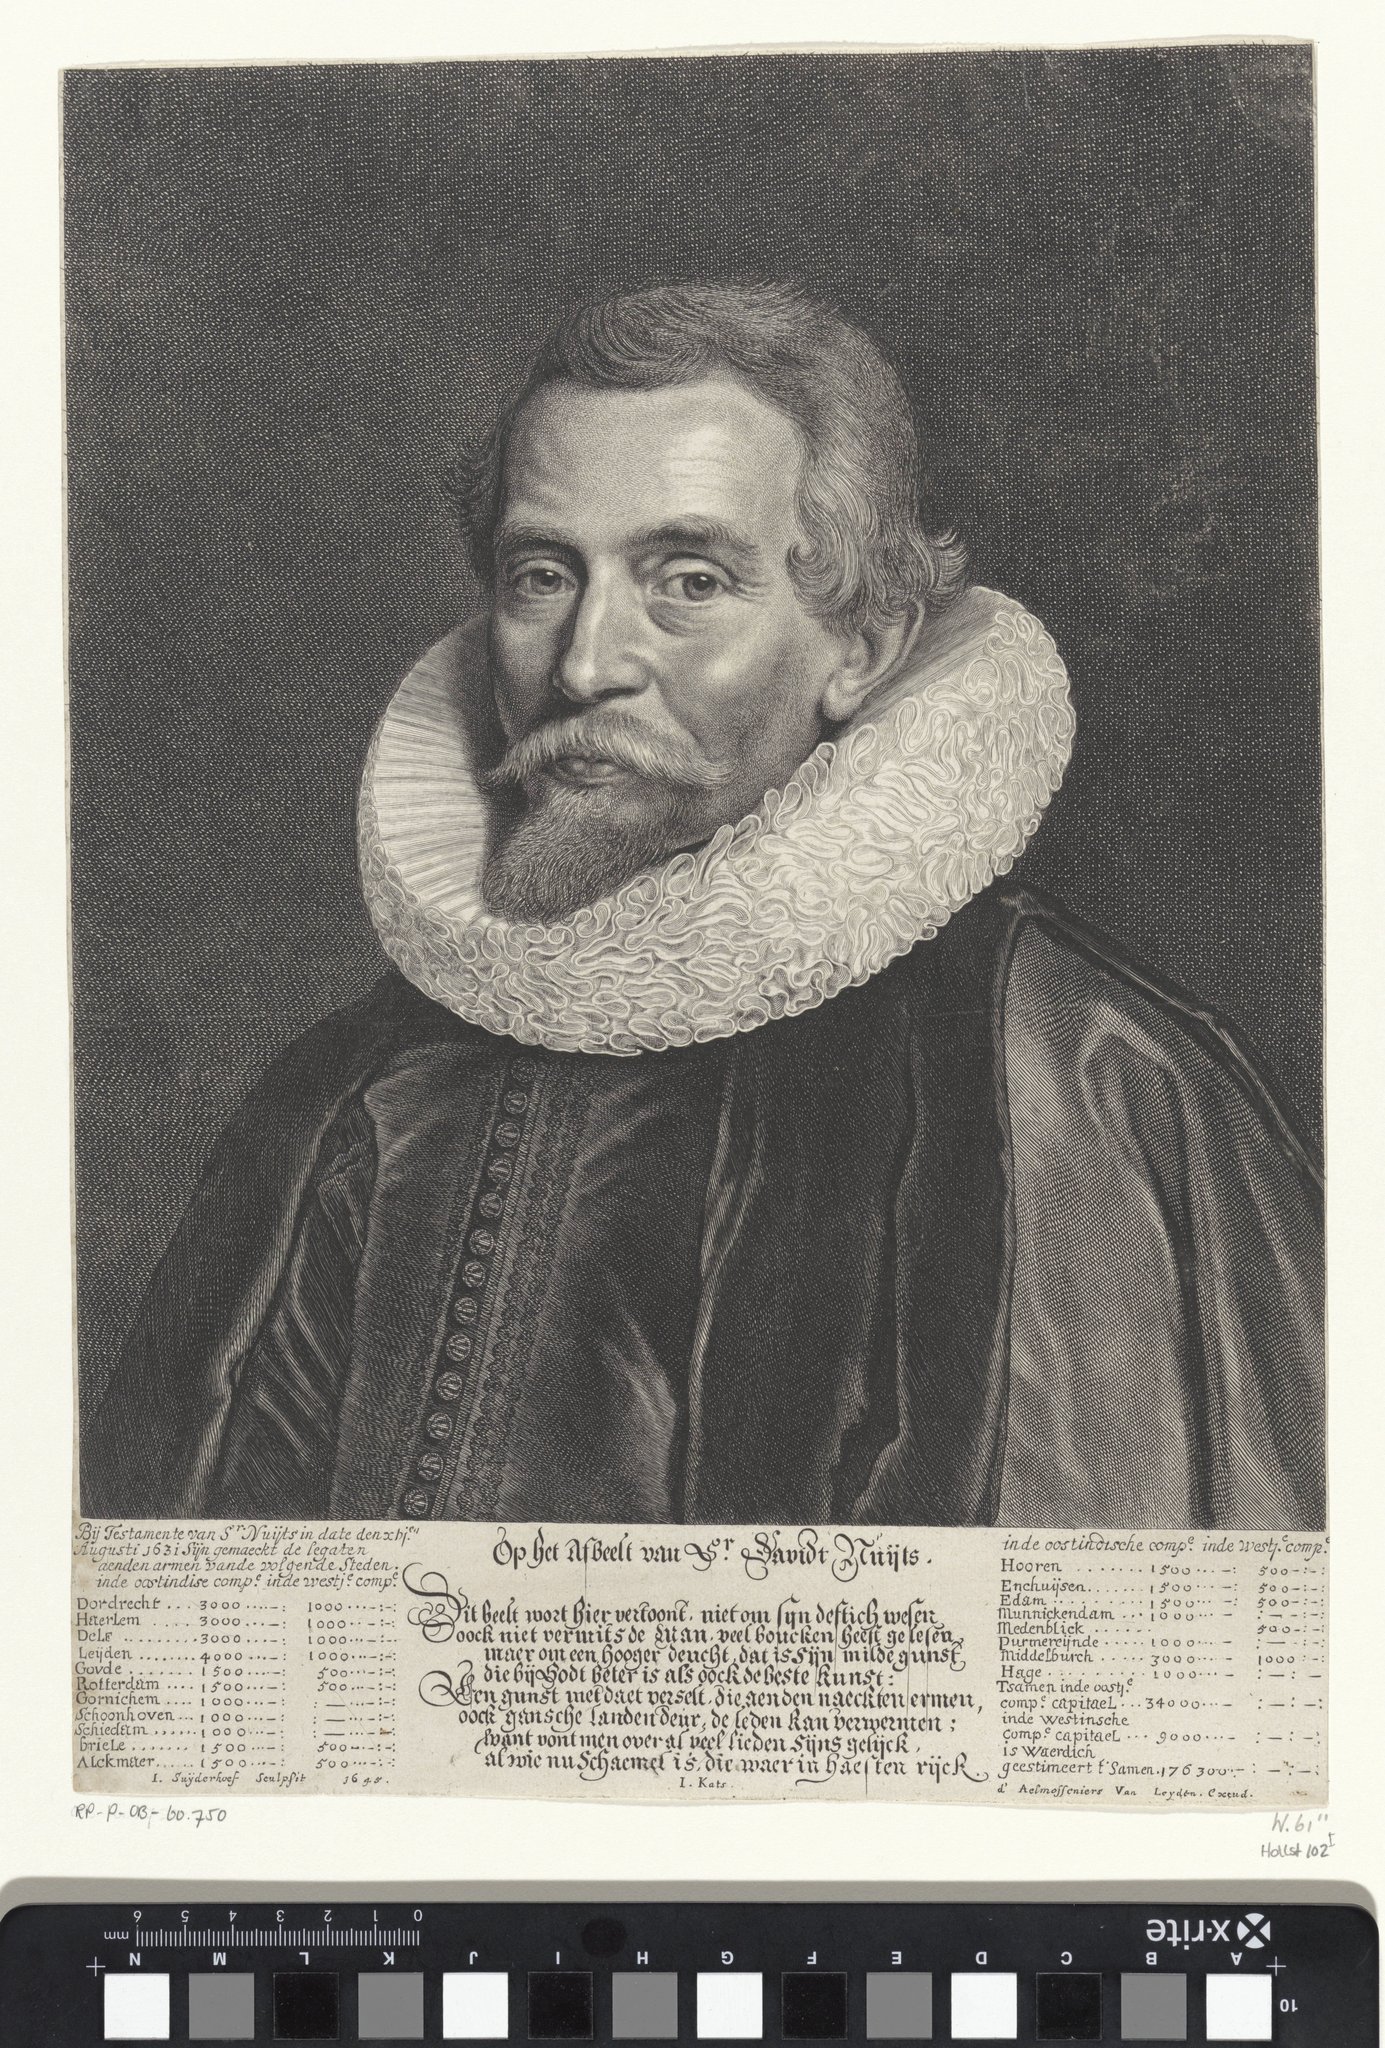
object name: print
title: Portret van David Nuyts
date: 1645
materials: paper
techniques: engraving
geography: leiden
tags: antwerp, the hague, neck-gear ~ clothing (with name) (+ men's clothes), historical persons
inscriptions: collector's mark: Lugt 240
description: Portret van David Nuyts, Antwerps koopman en bewindhebber van de Oost-Indische Compagnie. Nuyts is gekleed in een zwarte mantel waarboven een plooikraag. Onderaan in de marge zijn testament en een achtregelig vers in het Nederlands.